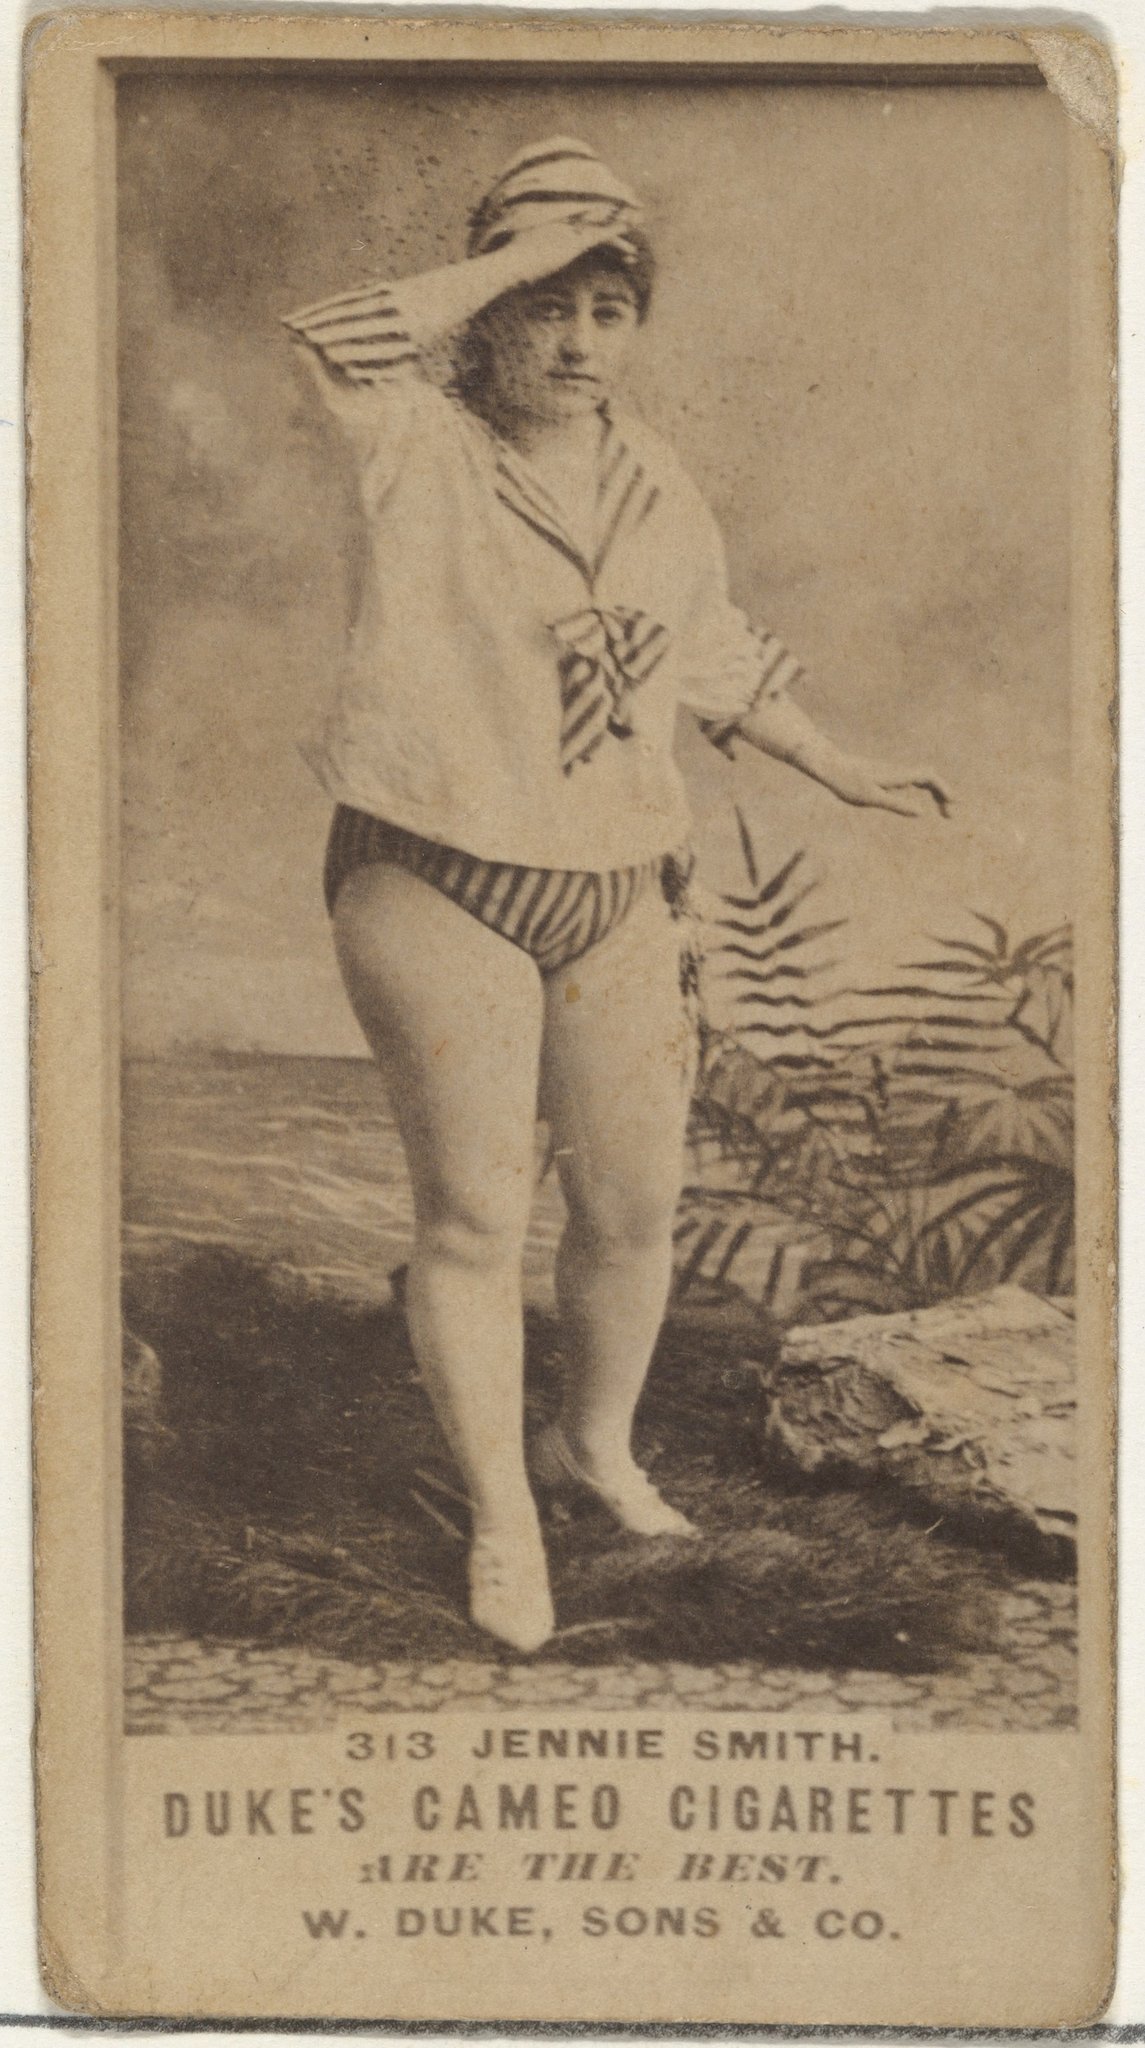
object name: photograph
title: Card Number 313, Jennie Smith, from the Actors and Actresses series (N145-5) issued by Duke Sons & Co. to promote Cameo Cigarettes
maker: w. duke, sons & co.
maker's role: publisher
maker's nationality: american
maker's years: 1870-1920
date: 1880-1889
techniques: albumen silver print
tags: portraits,women,actresses